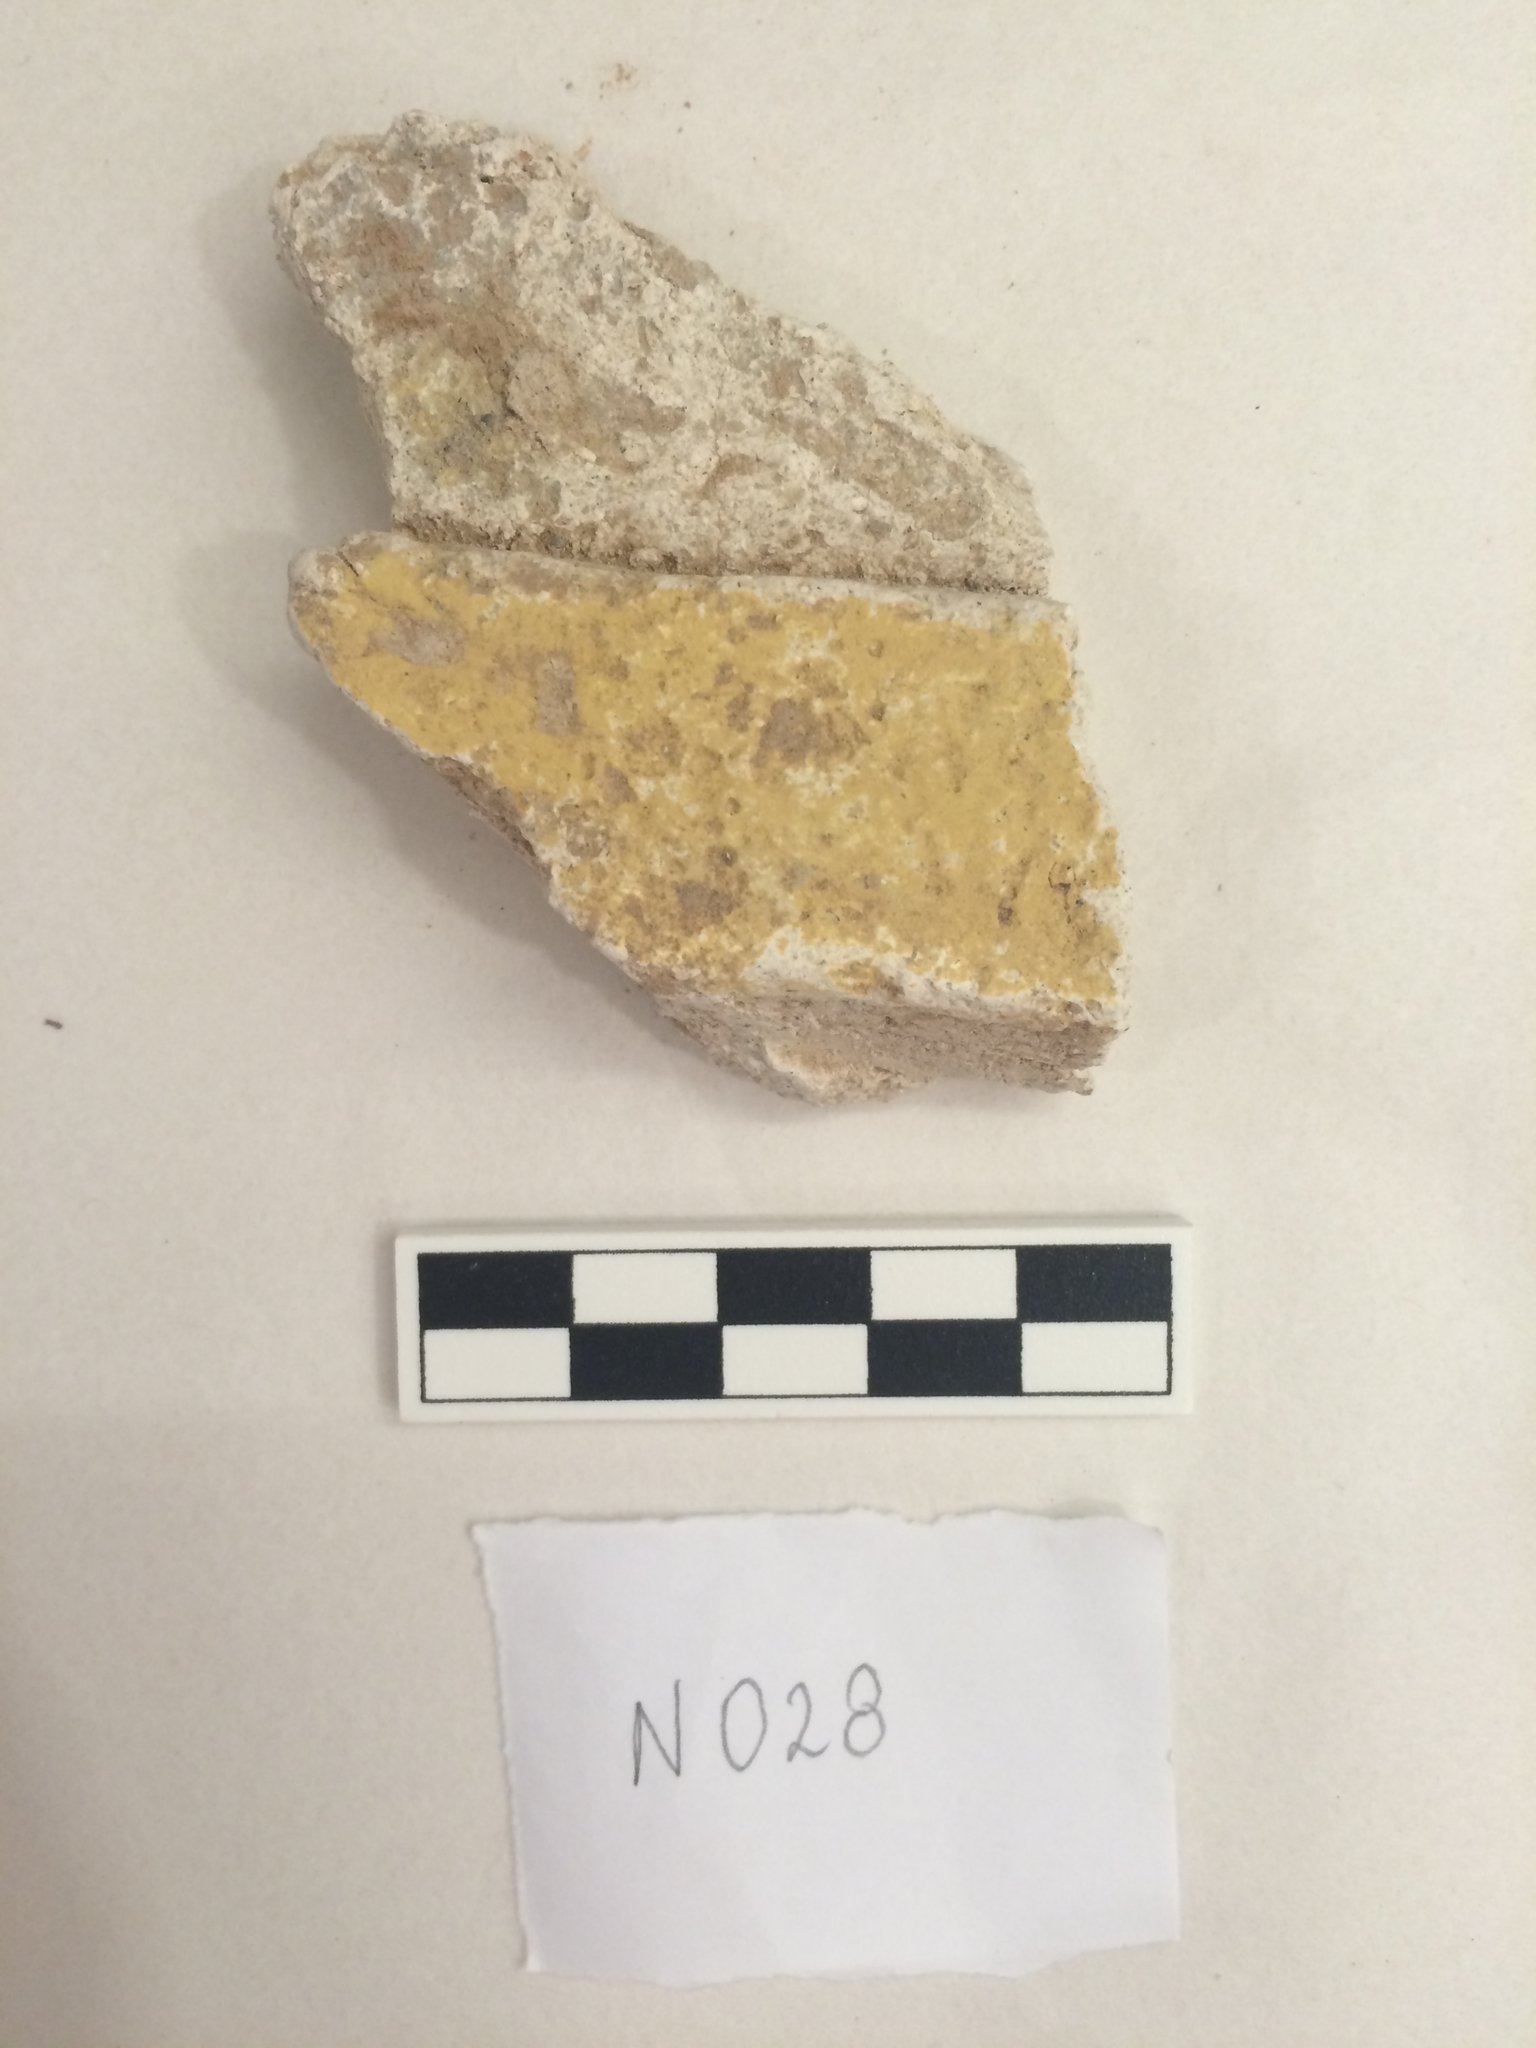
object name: fragment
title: Stucco Fragment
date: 701-1200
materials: plaster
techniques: carving, painting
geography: iran